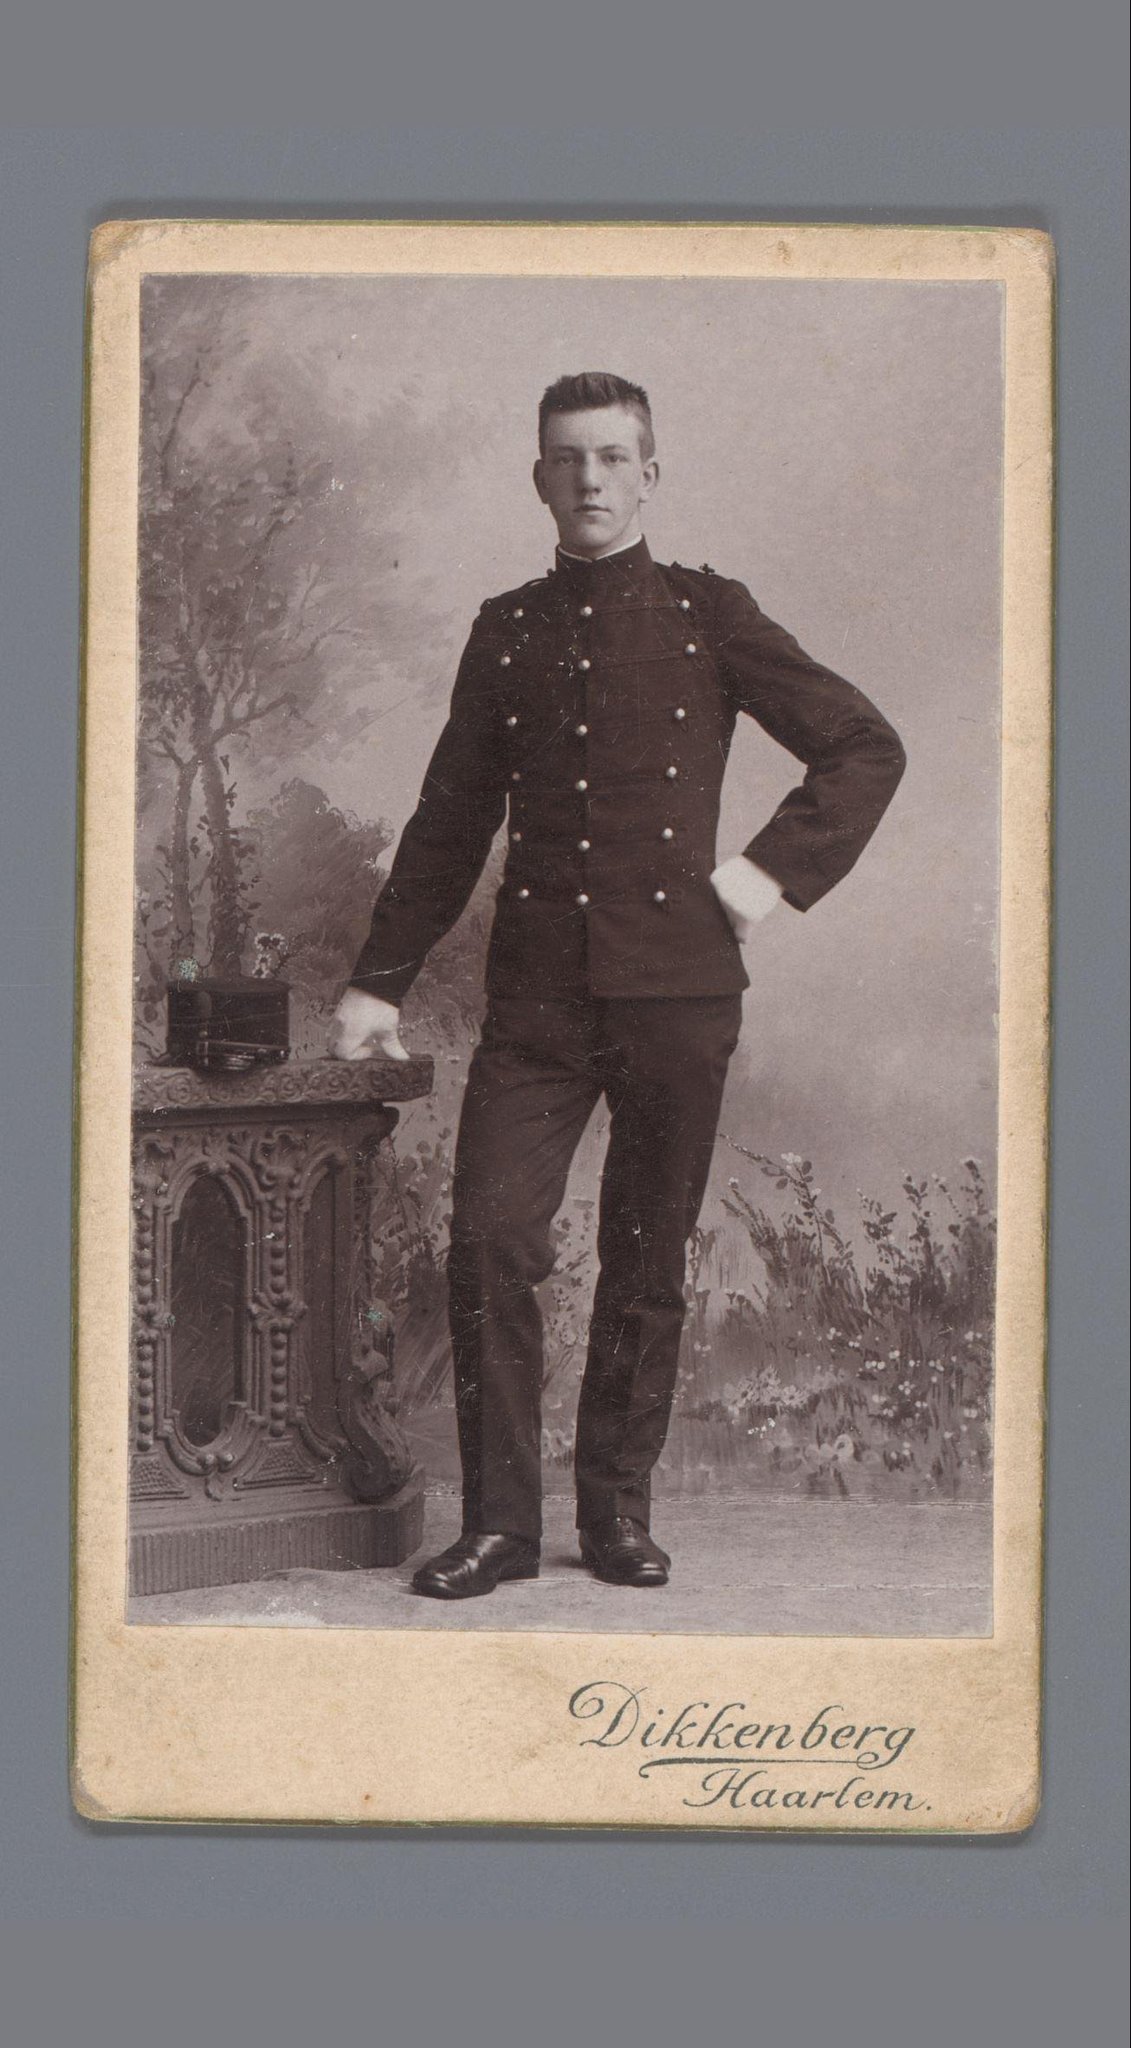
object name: carte de visite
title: Portret van een onbekende jonge man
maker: willem hendrik dikkenberg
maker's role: fotograaf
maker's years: 1872-1946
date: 1897-1914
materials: paper, cardboard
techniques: collodion silver print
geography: haarlem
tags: youth, adolescent, anonymous historical person portrayed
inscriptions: inscription: ‘De Plaat blijft voor/ nabestelling bewaard.’, address: ‘Ged. Oudegracht 70/ Haarlem.’